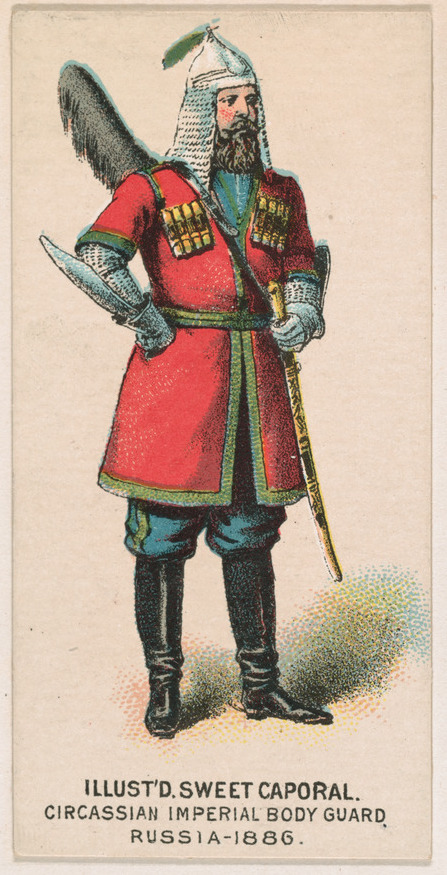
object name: print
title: Circassian Imperial Bodyguard, Russia, 1886, from the Military Series (N224) issued by Kinney Tobacco Company to promote Sweet Caporal Cigarettes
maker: kinney brothers tobacco company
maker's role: publisher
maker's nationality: american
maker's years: 1869-2011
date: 1888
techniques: color lithograph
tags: military,swords,men